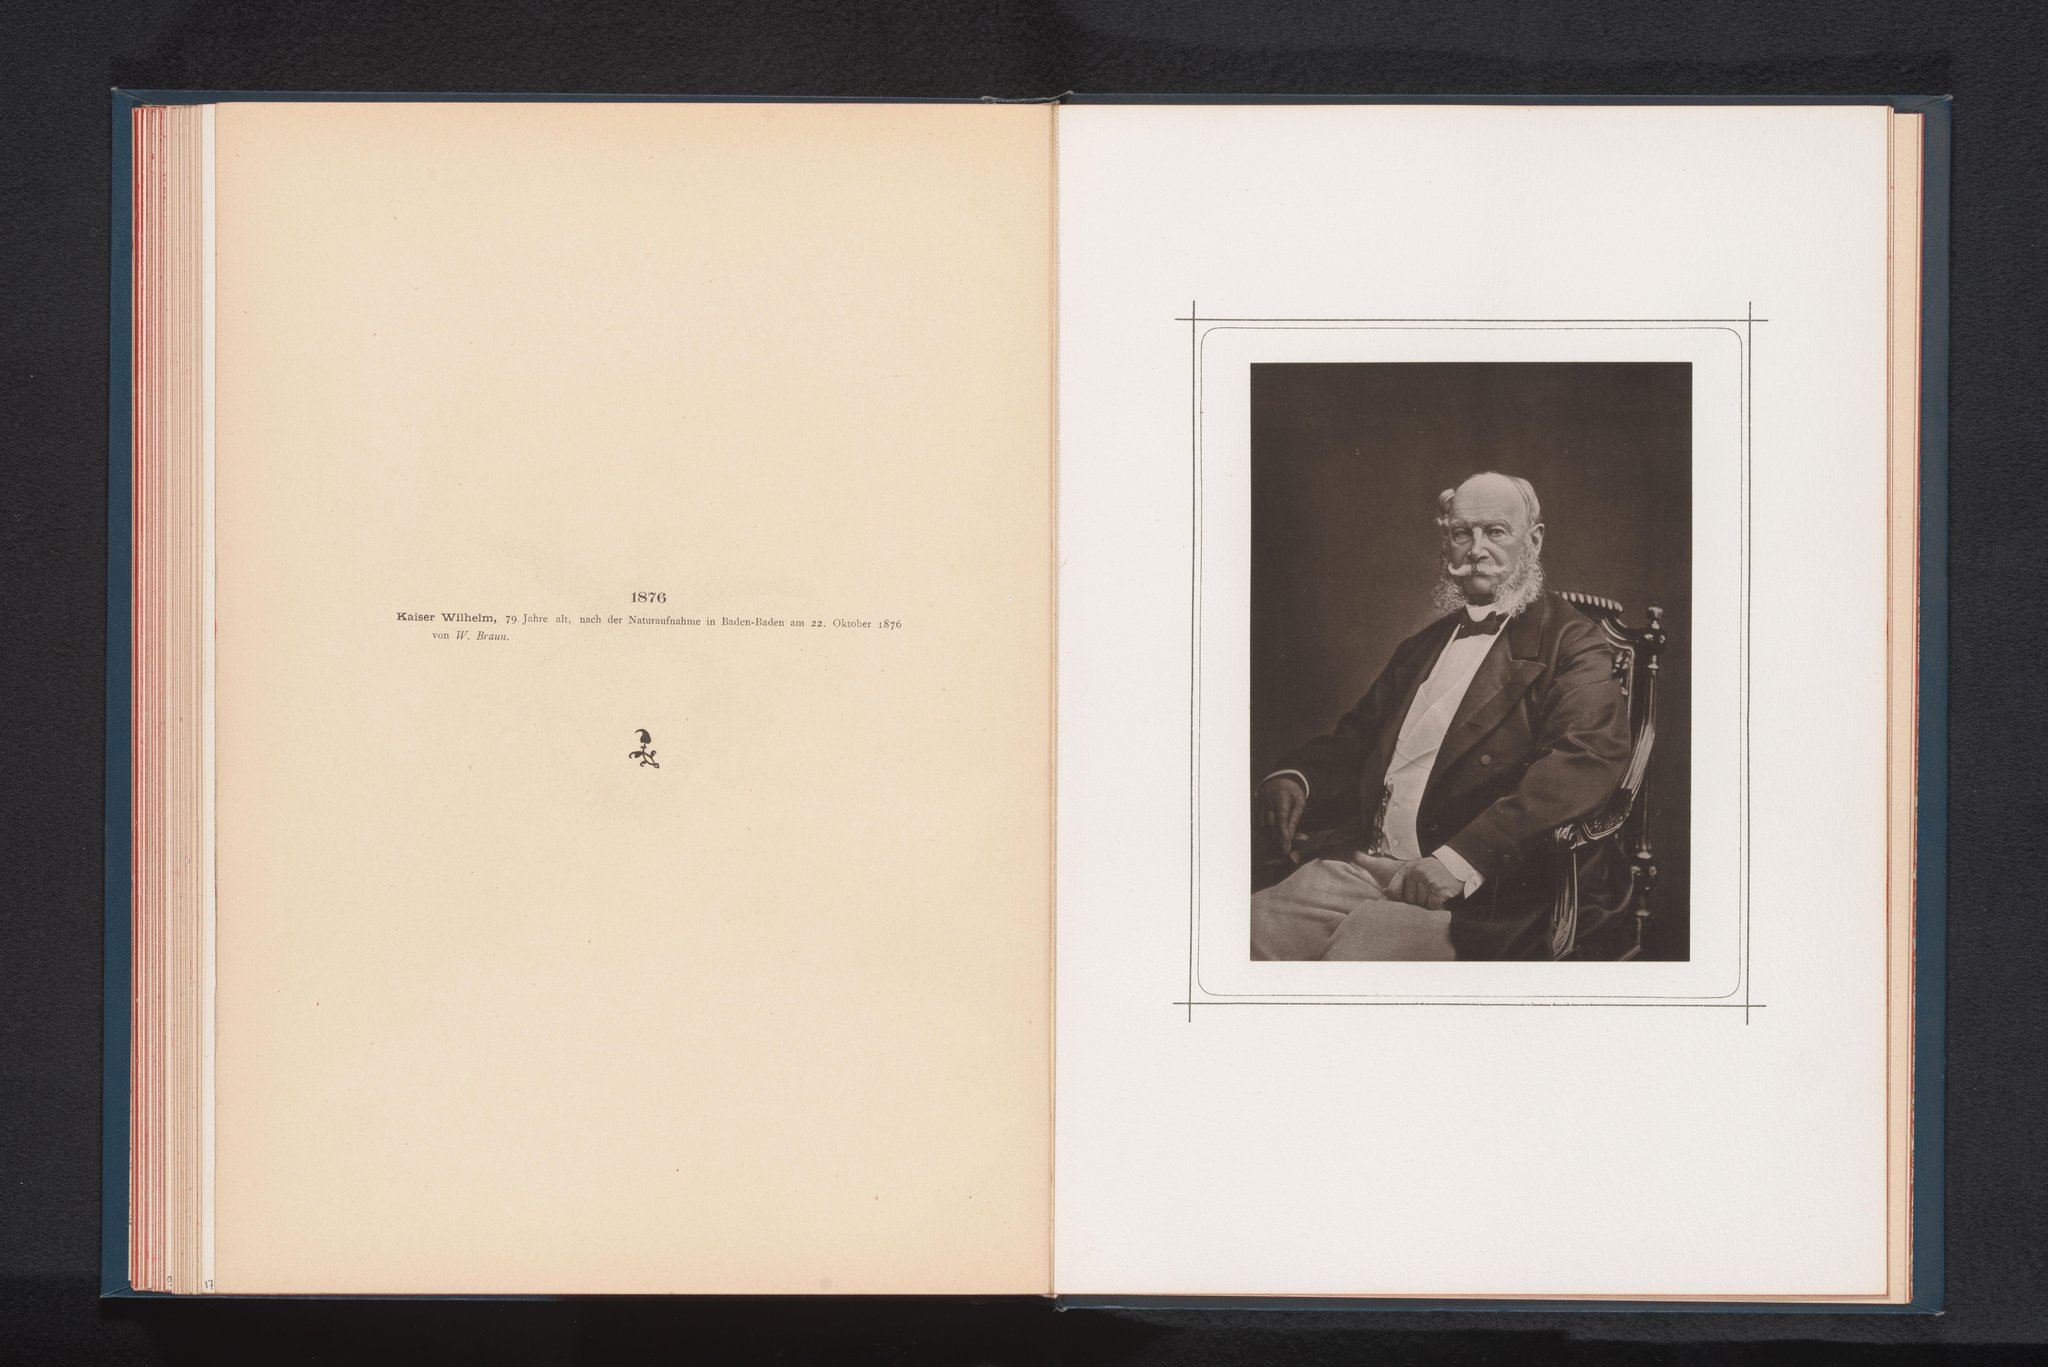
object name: photomechanical print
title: Portret van Wilhelm I op een leeftijd van 79 jaar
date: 1876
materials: paper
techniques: photograph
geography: baden-baden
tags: berlin, wilhelm i (keizer van duitsland), ruler, sovereign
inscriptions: inscription: ‘1876 Kaiser Wilhelm, 79 Jahre alt, nach der Naturaufnahme in Baden-Baden am 22. Oktober 1876 von W. Braun.’